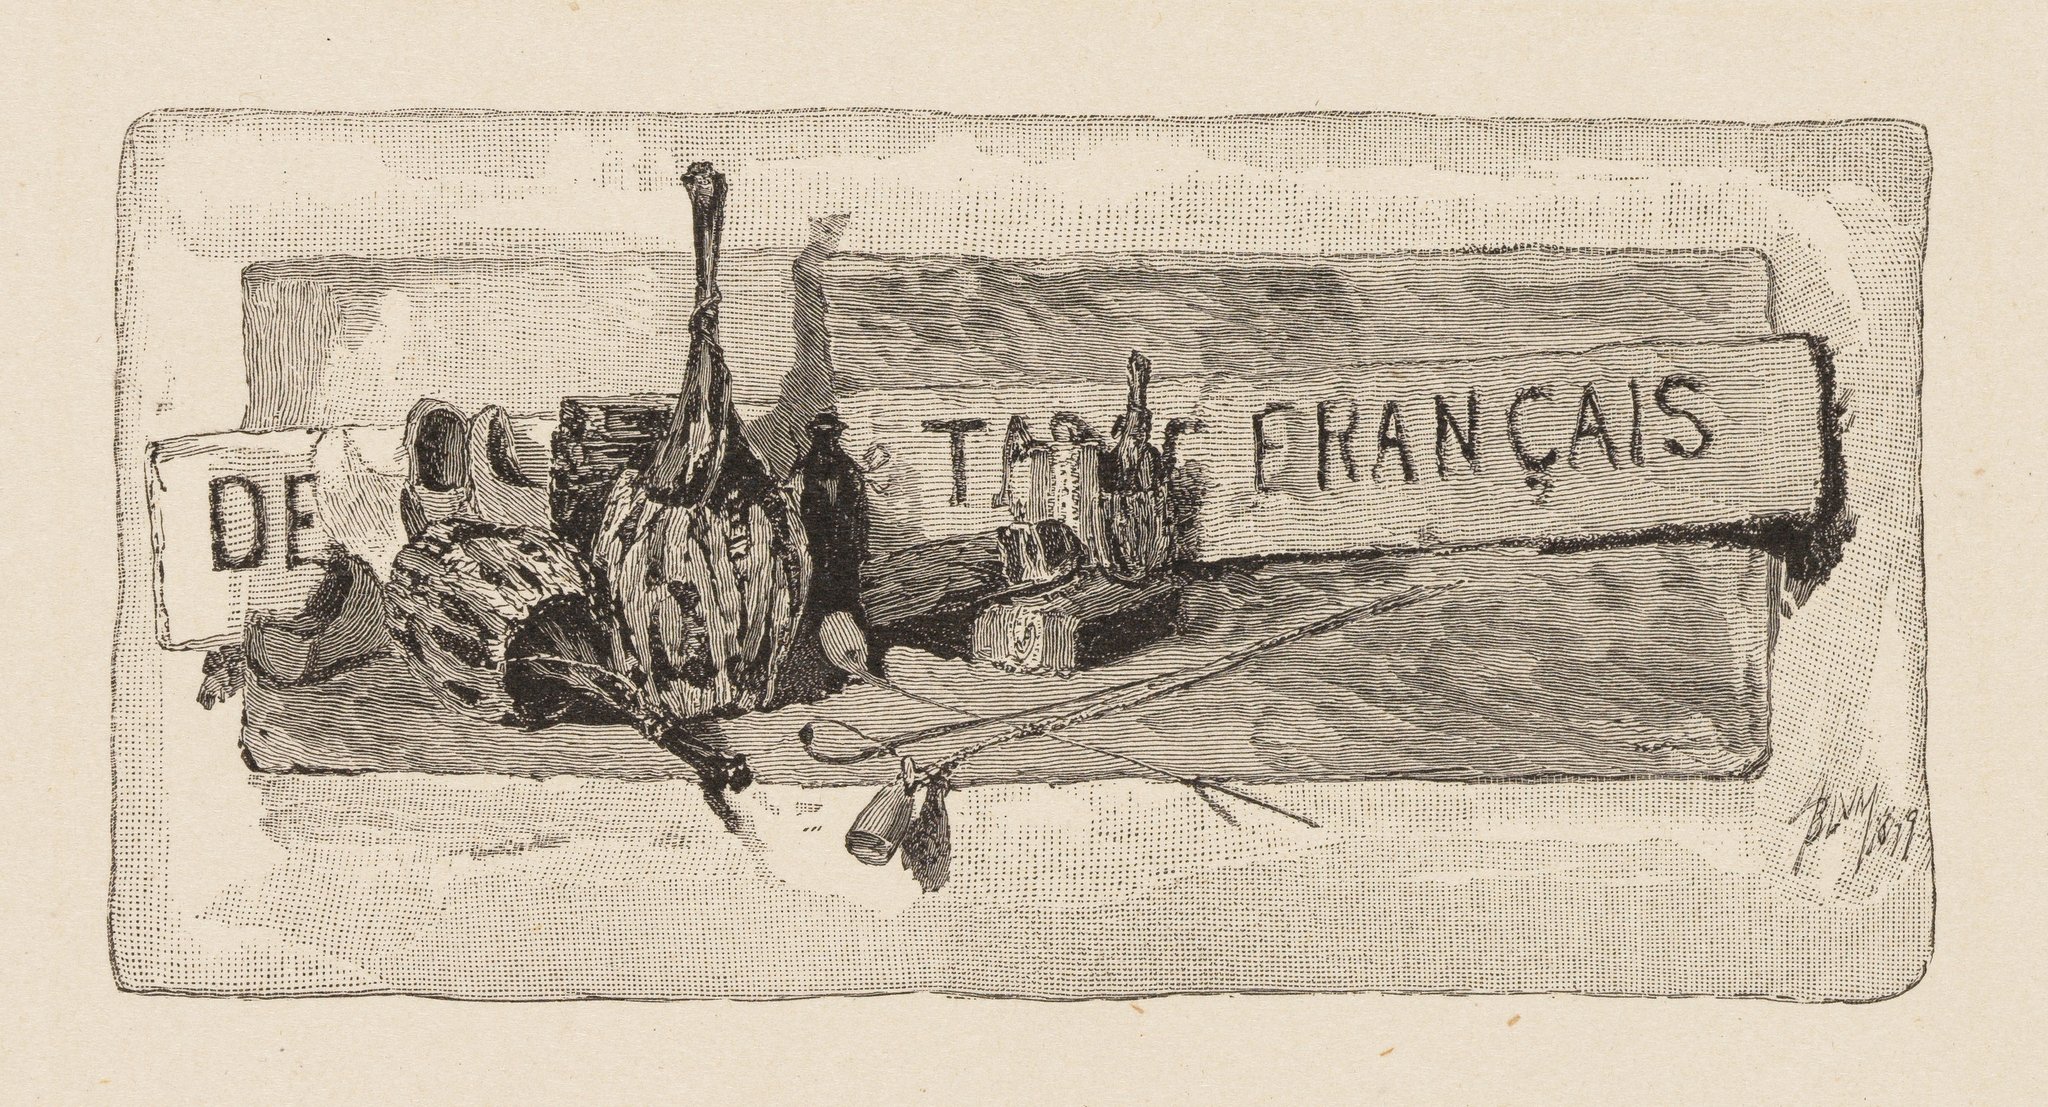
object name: print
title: Tail-Piece French Quarters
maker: elbridge kingsley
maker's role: artist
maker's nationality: american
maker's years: 1841-1918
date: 1860-1915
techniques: engraving